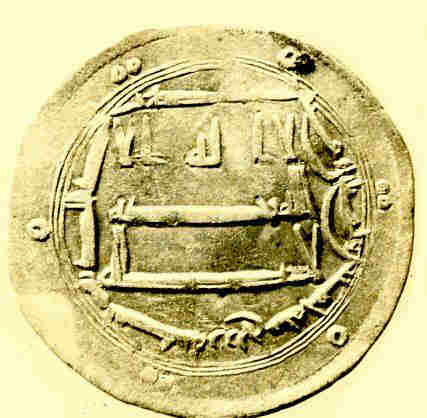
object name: coin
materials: silver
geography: zaranj